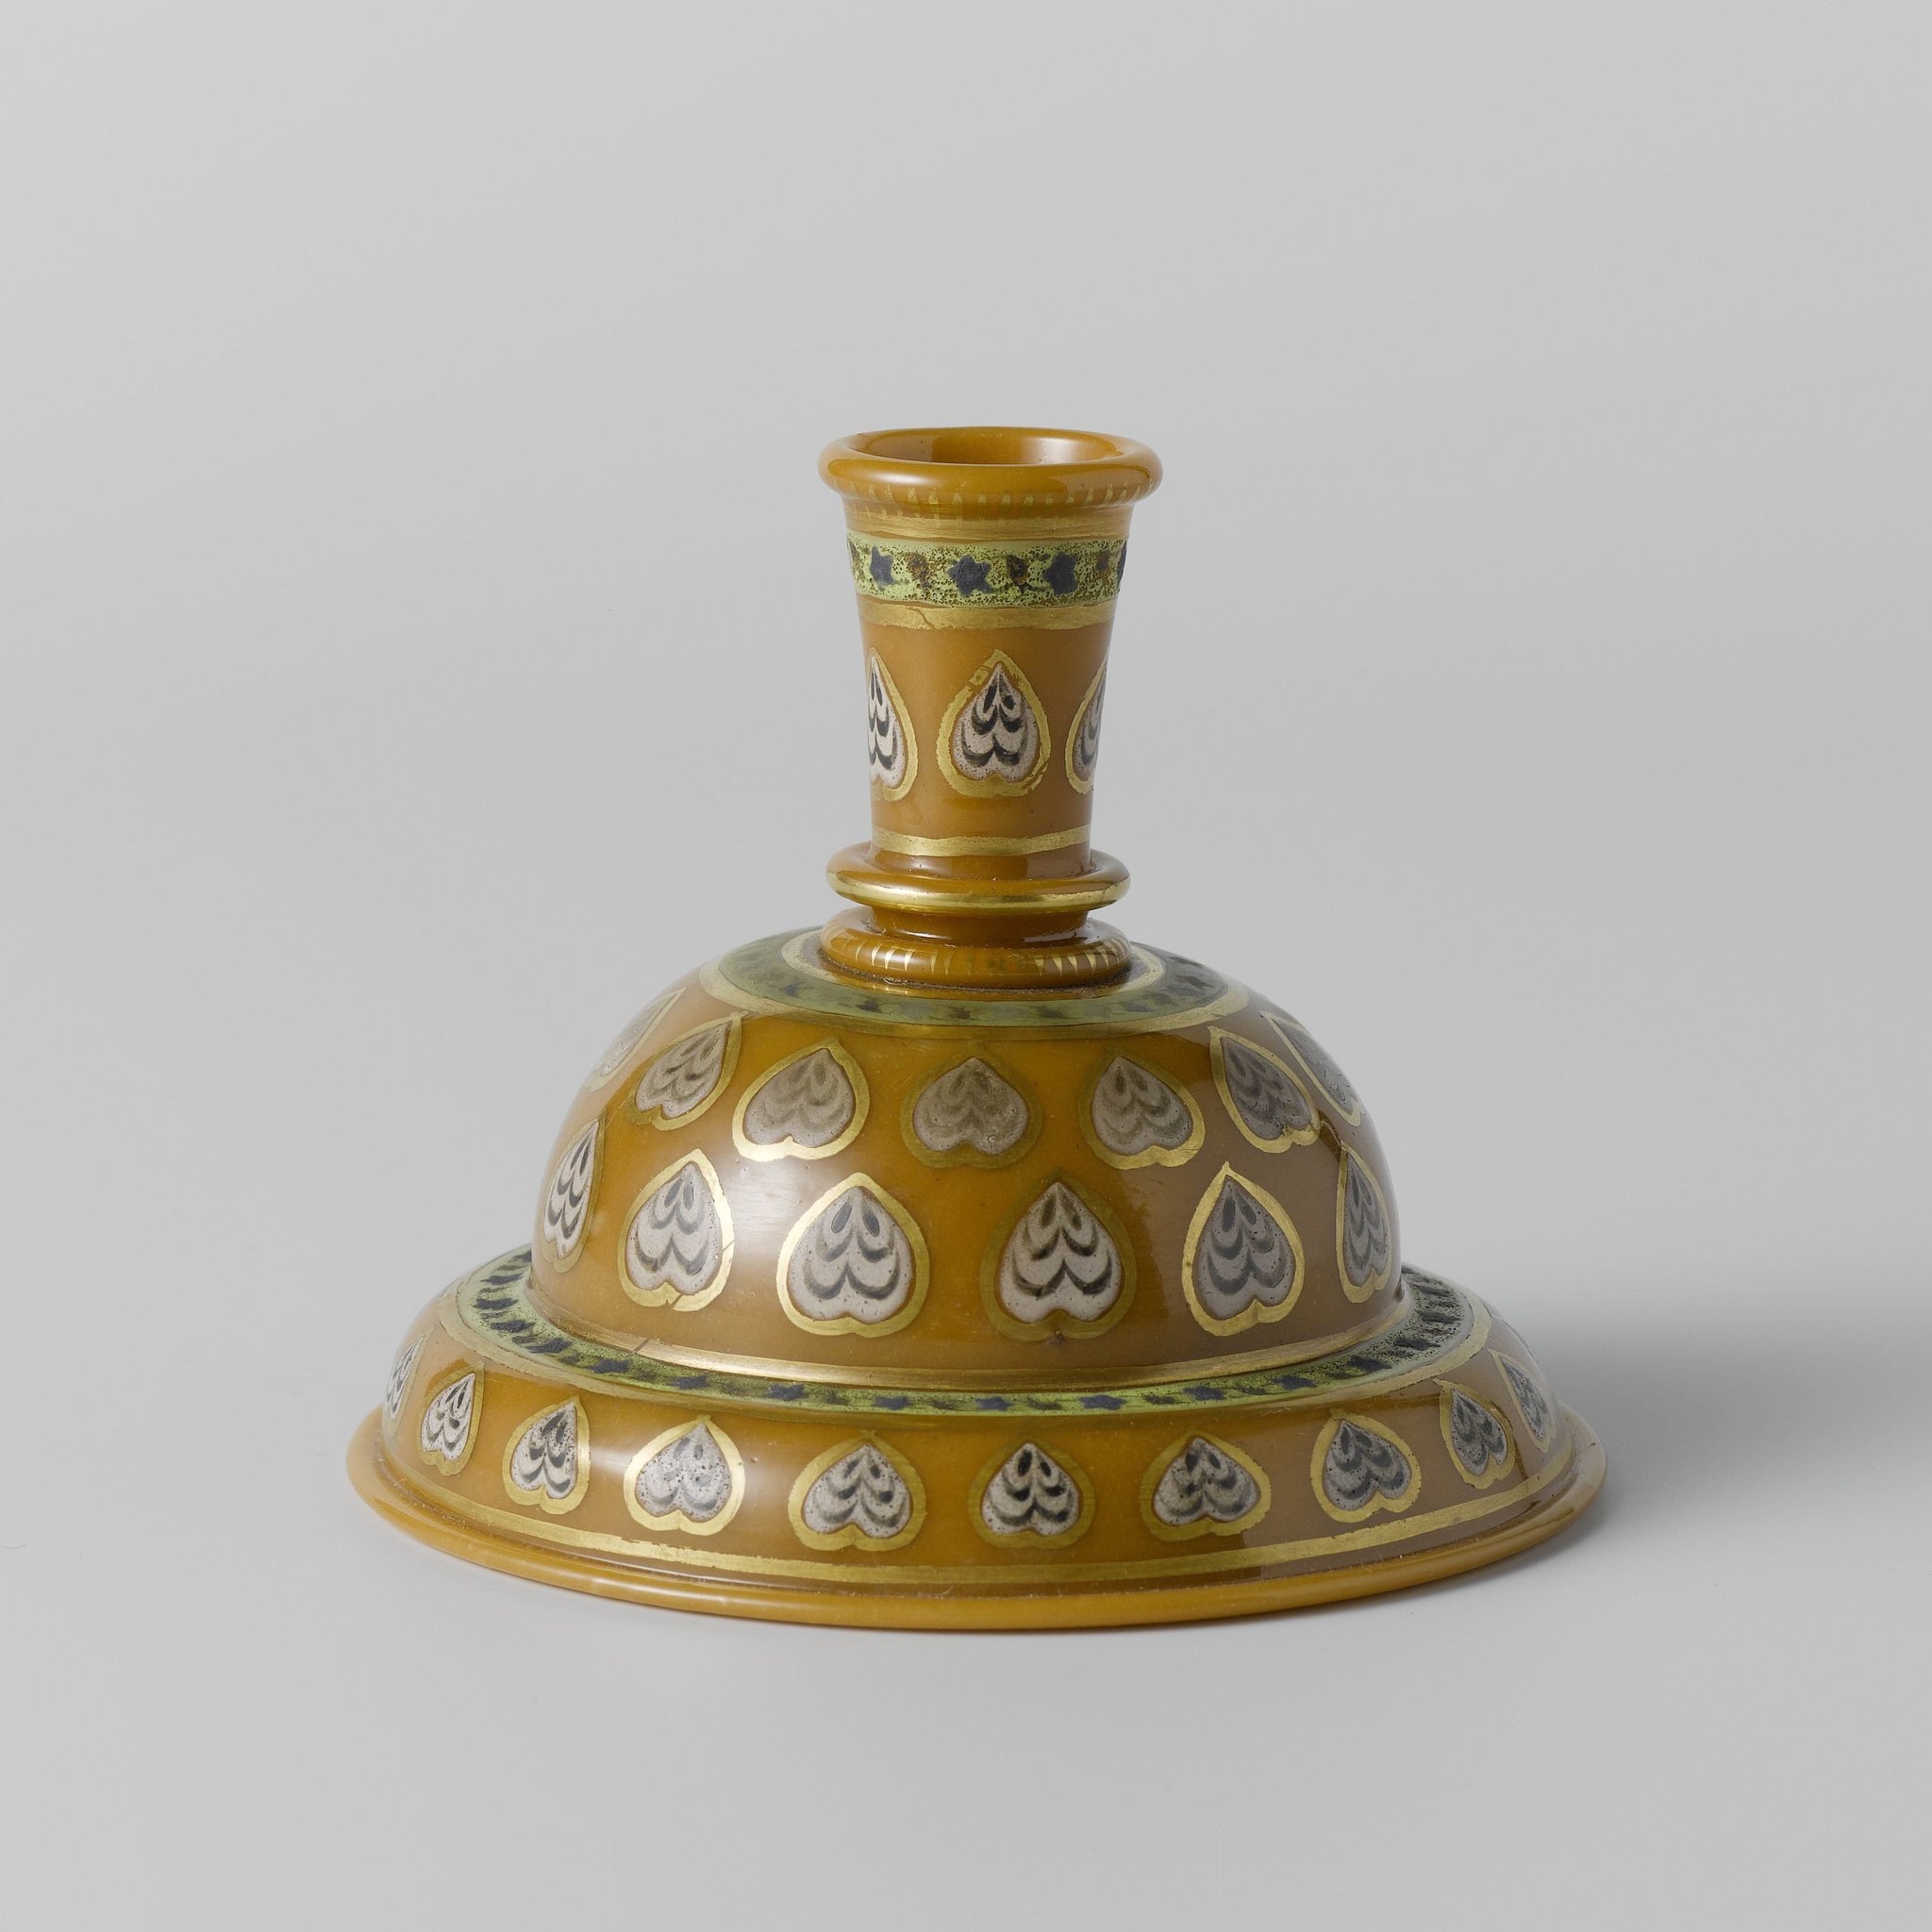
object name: water pipe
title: Tabakskom van een waterpijp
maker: Anonymous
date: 1775-1810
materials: glass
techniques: gilding, glassblowing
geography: north india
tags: the hague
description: Gladde standring, concave stam, ronde kom met uitstaande rand. Gedecoreerd met gestileerde florale motieven in roze, zwart en goud, met drie groene lijnen. Er is een gat geboord in de bodem.